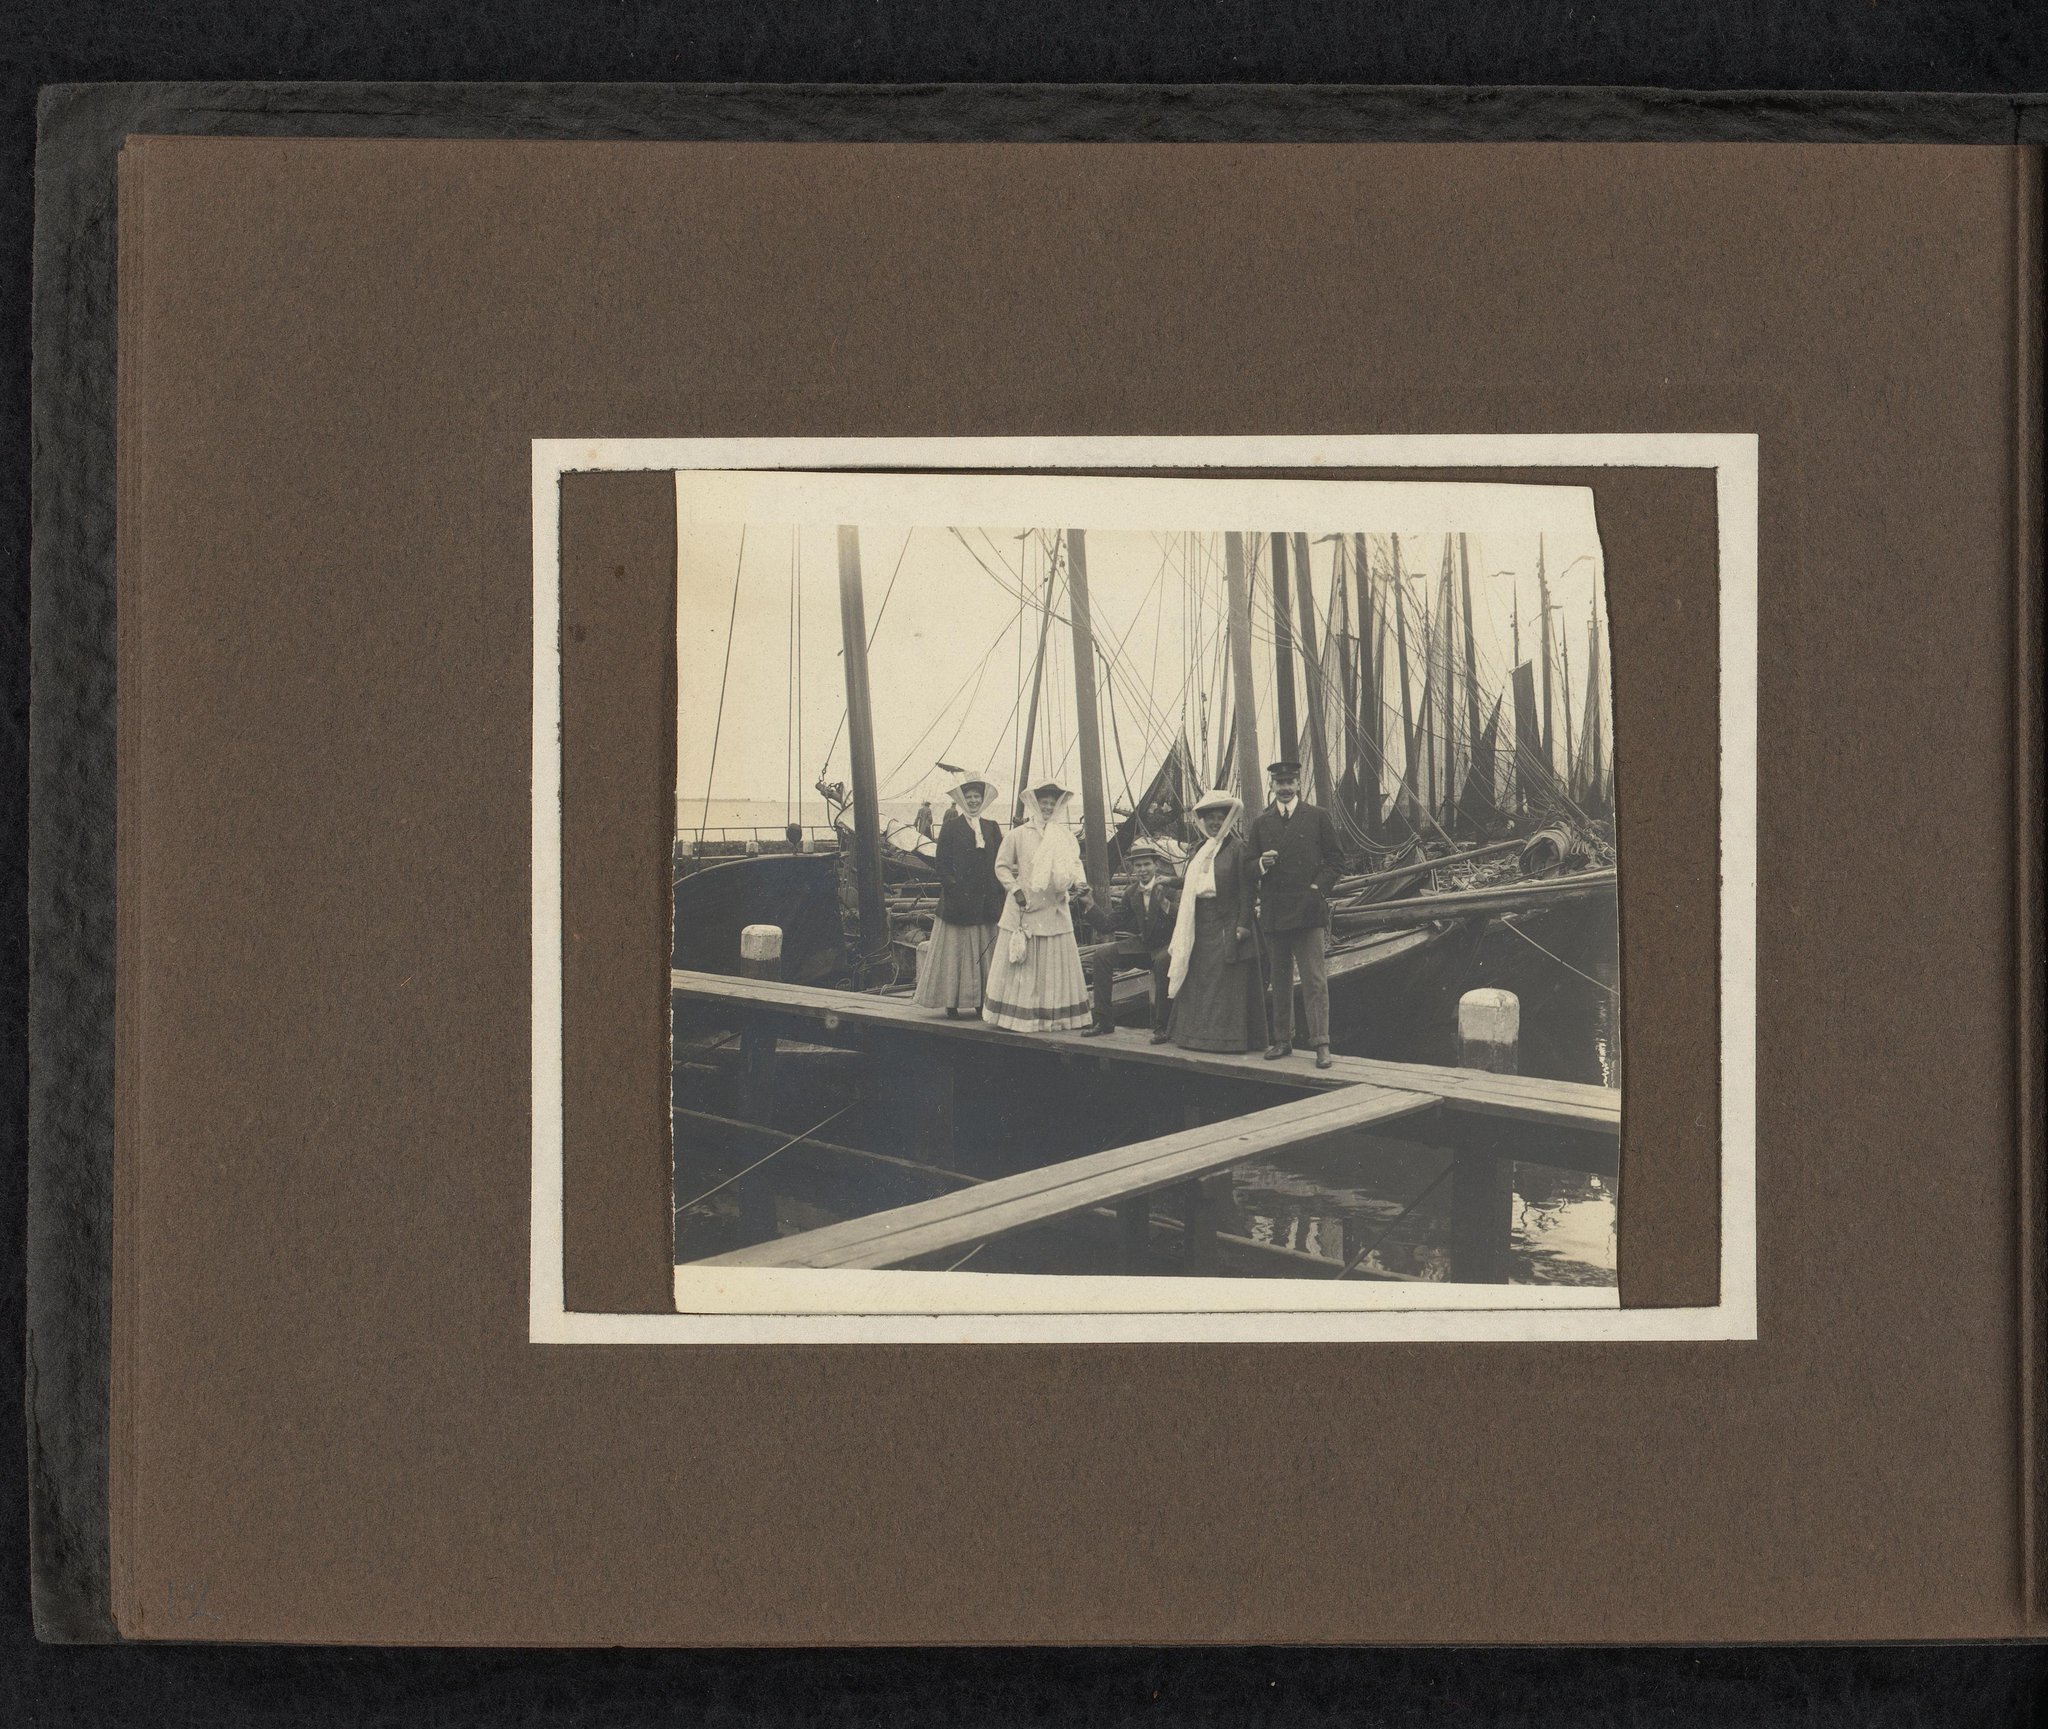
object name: album leaf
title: Gezelschap op een steiger, rechts staat Hendrik Herman van den Berg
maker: hendrik herman van den berg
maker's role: amateurfotograaf, jurist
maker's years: 1875-1944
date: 1908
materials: paper, cardboard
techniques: gelatin silver print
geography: alphen aan den rijn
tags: harbour, historical persons, pier, quay, wharf